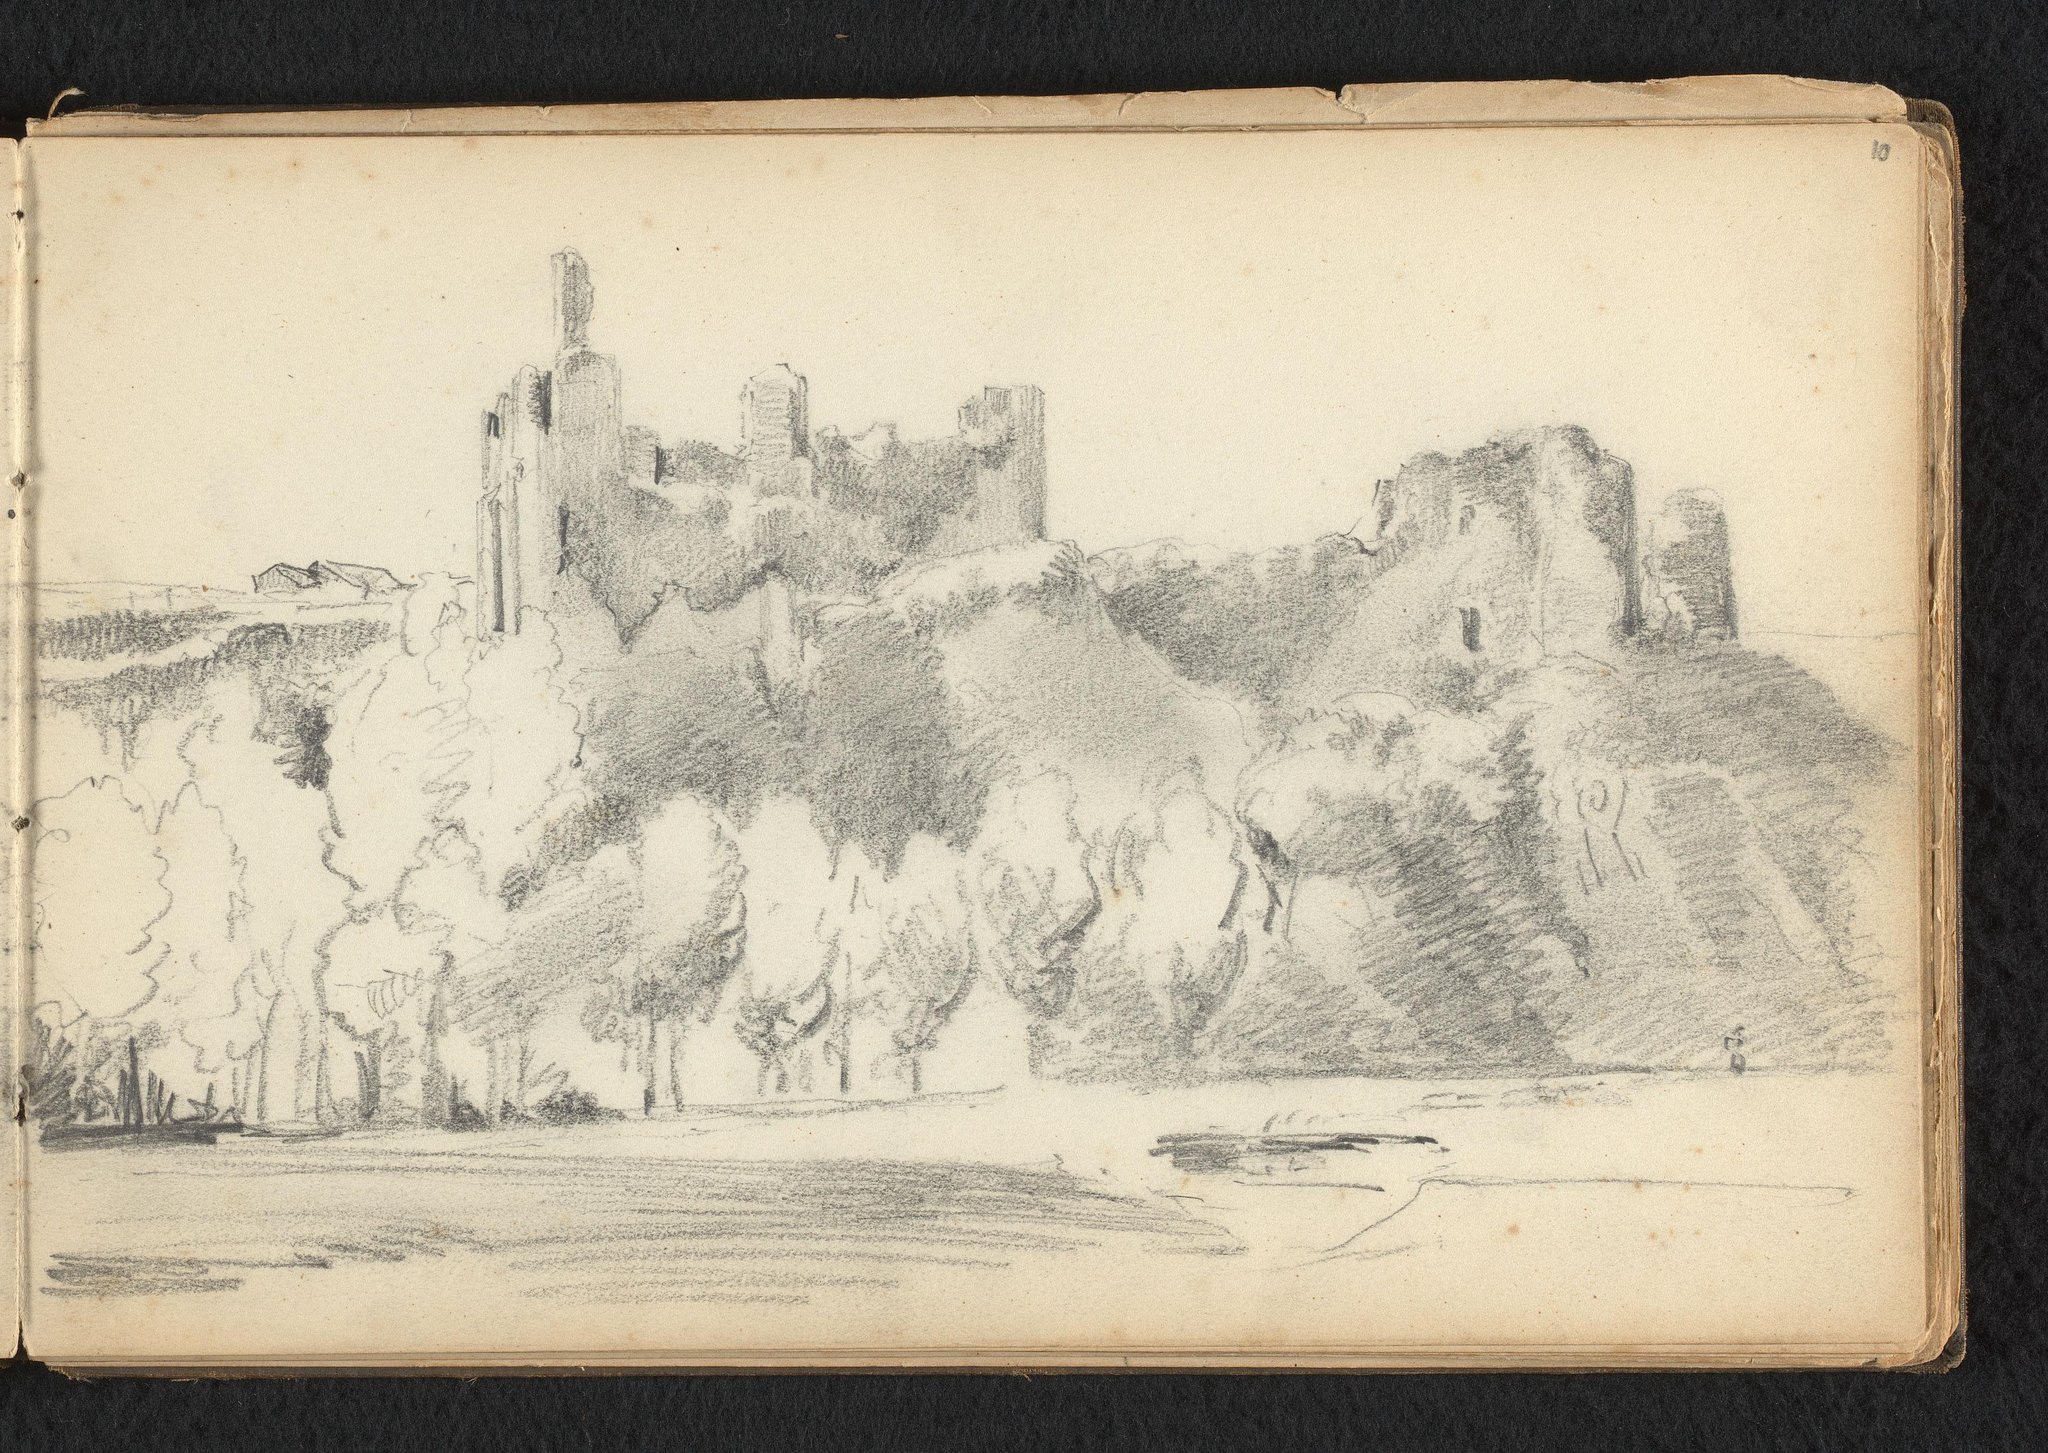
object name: sketchbook leaf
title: Landschap met ruïne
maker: jan bedijs tom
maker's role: draughtsman, painter, print maker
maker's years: 1813-1894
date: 1823-1894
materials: paper, pencil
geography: the hague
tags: landscape with ruins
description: Pagina 10 recto uit een schetsboek met 37 bladen.